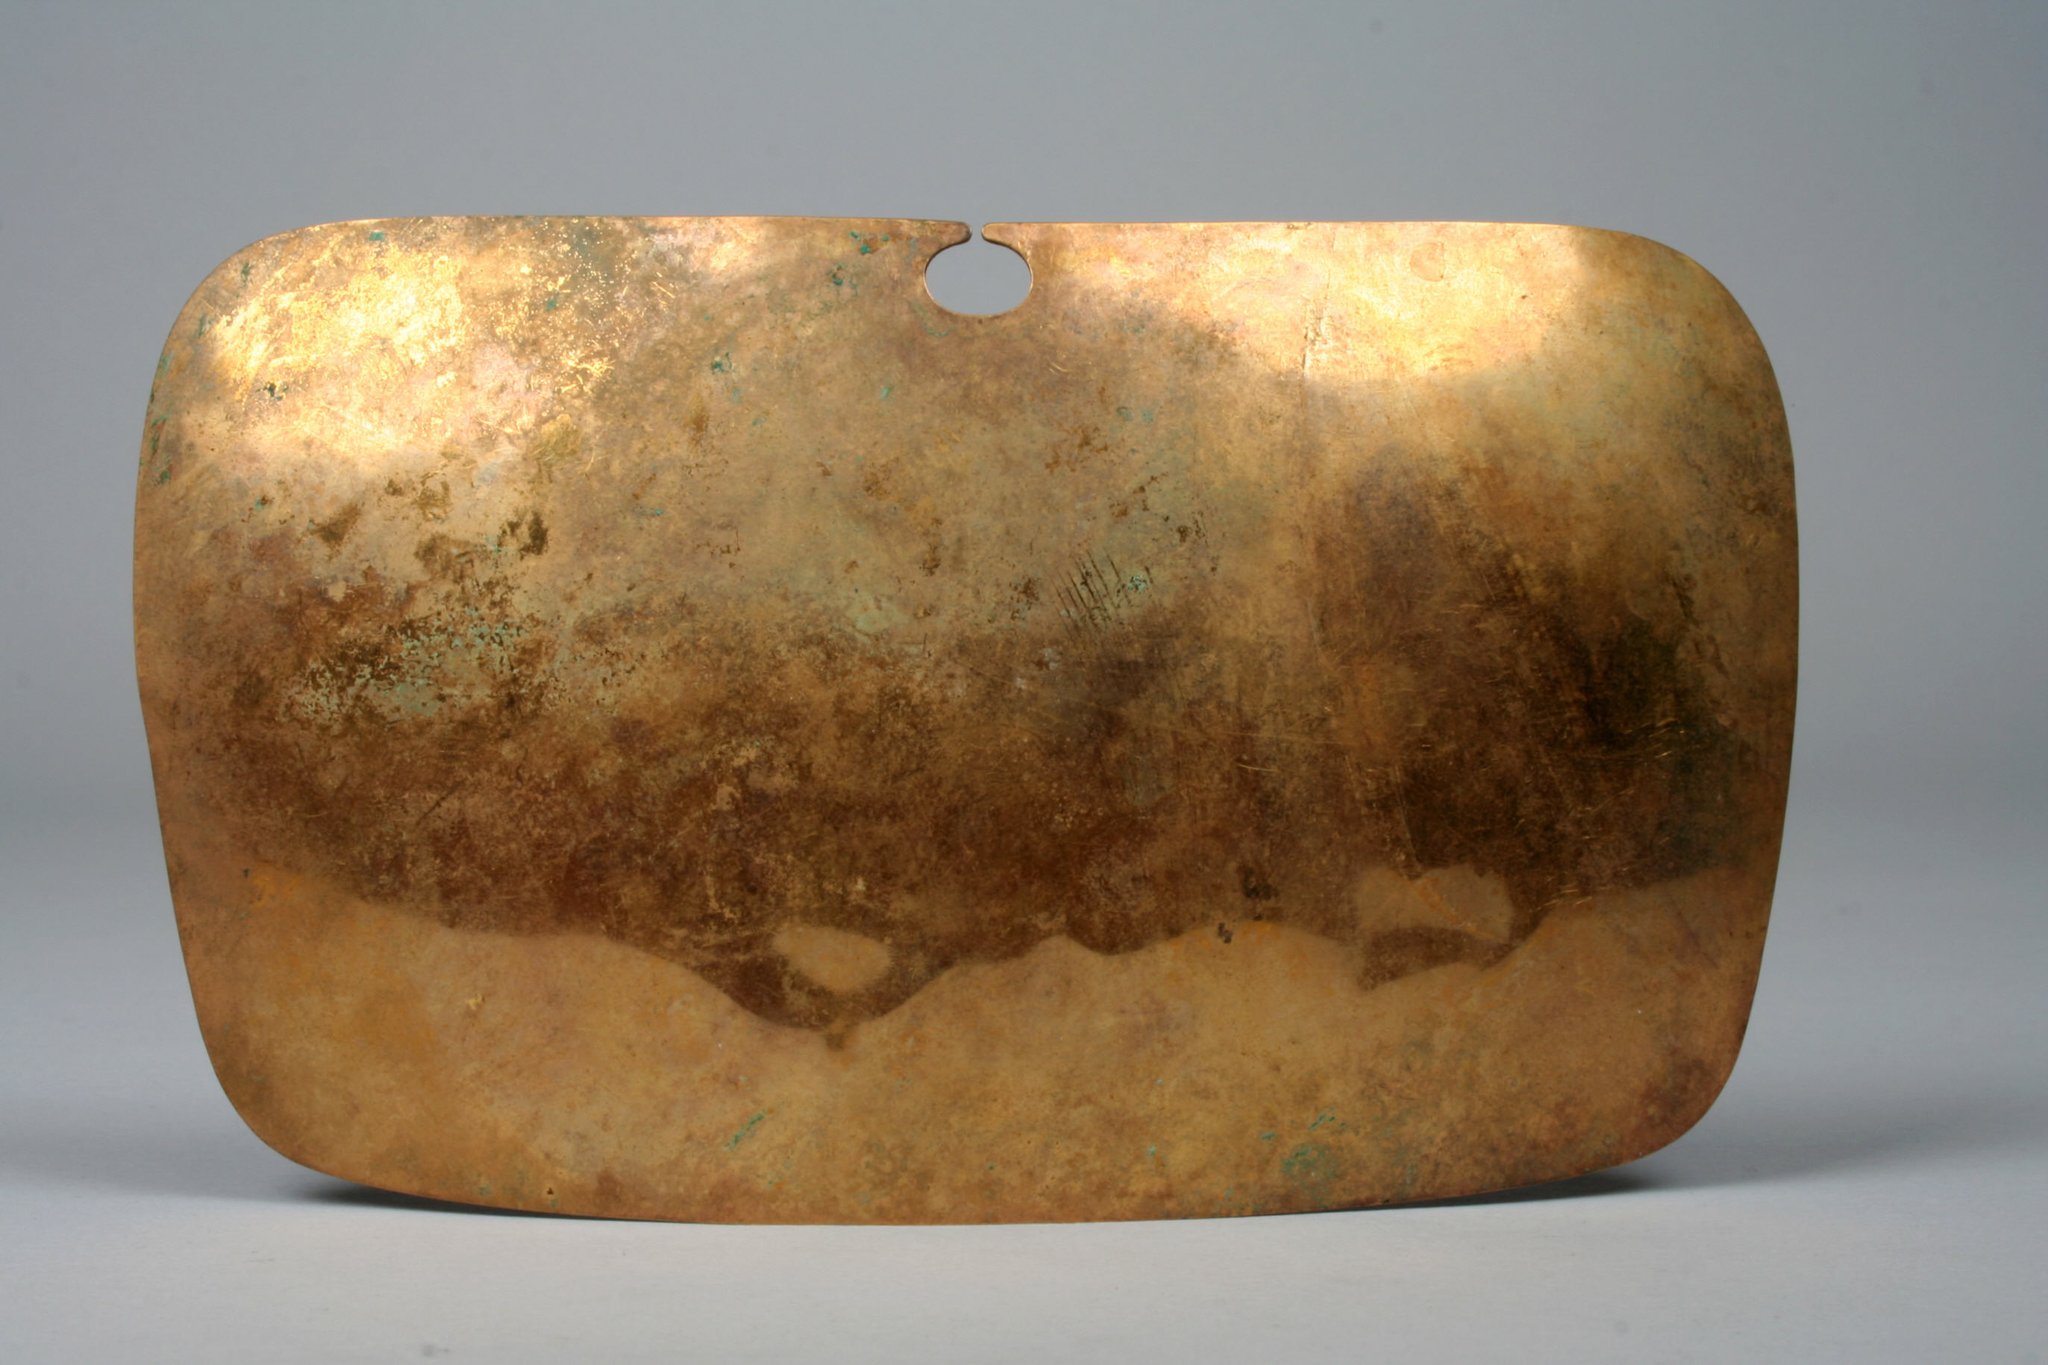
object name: nose ornament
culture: moche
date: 1-300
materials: gold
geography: peru